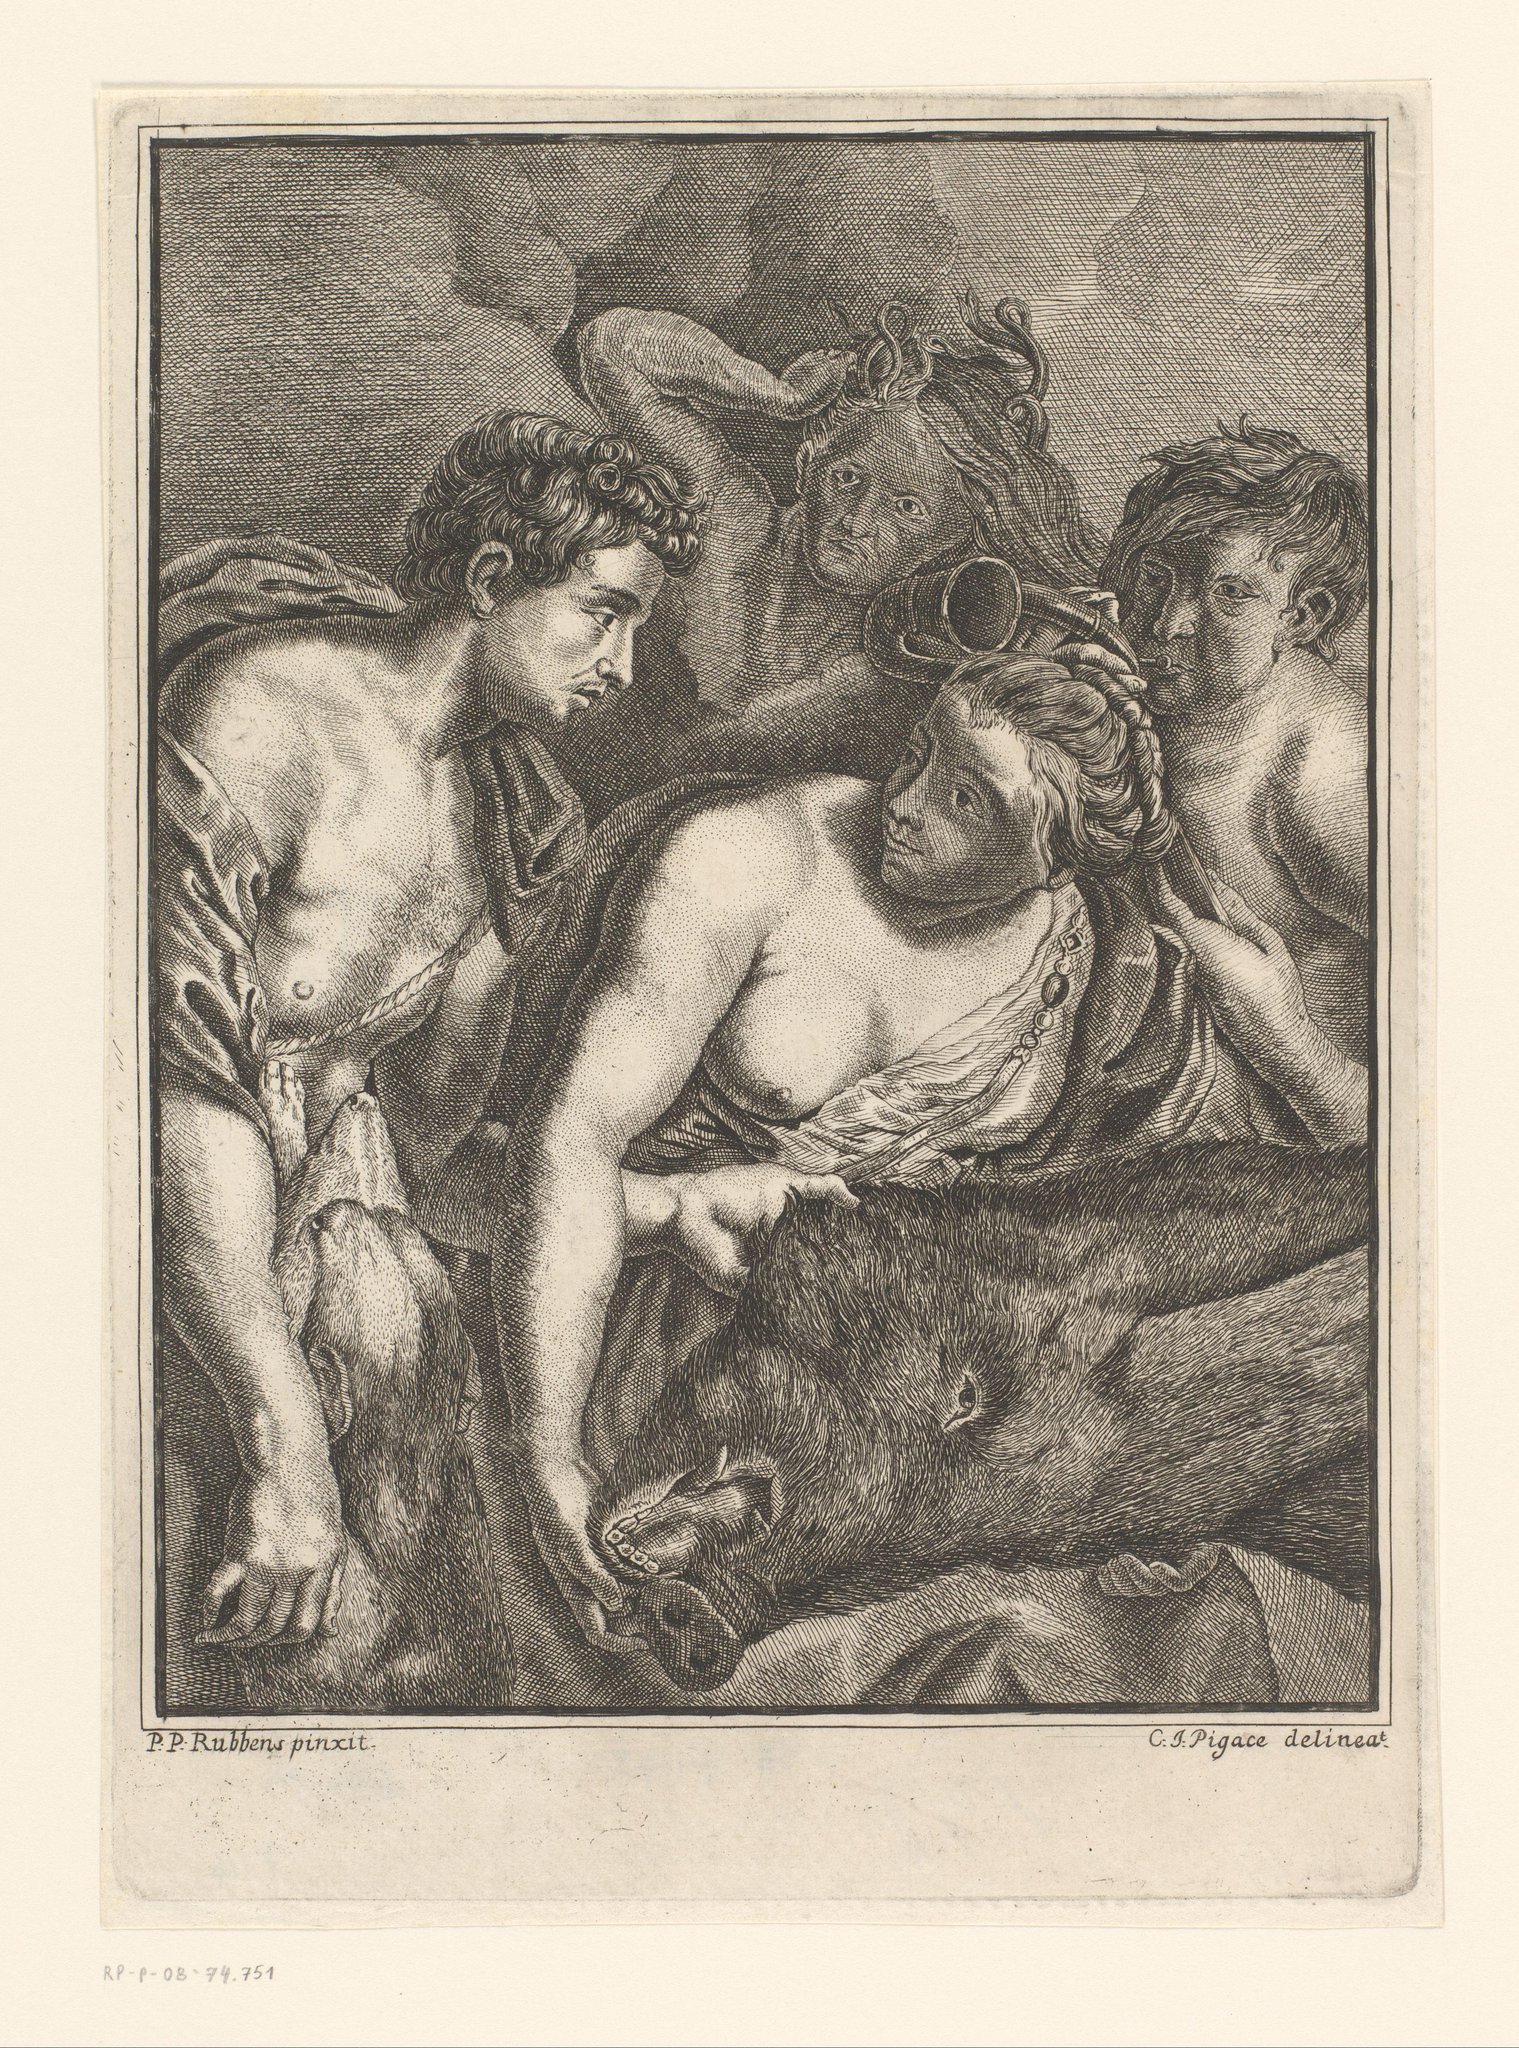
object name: print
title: Meleager en Atalante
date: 1738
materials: paper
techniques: engraving, etching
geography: france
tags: meleager gives the head of the boar to atalanta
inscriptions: collector's mark: Lugt 240